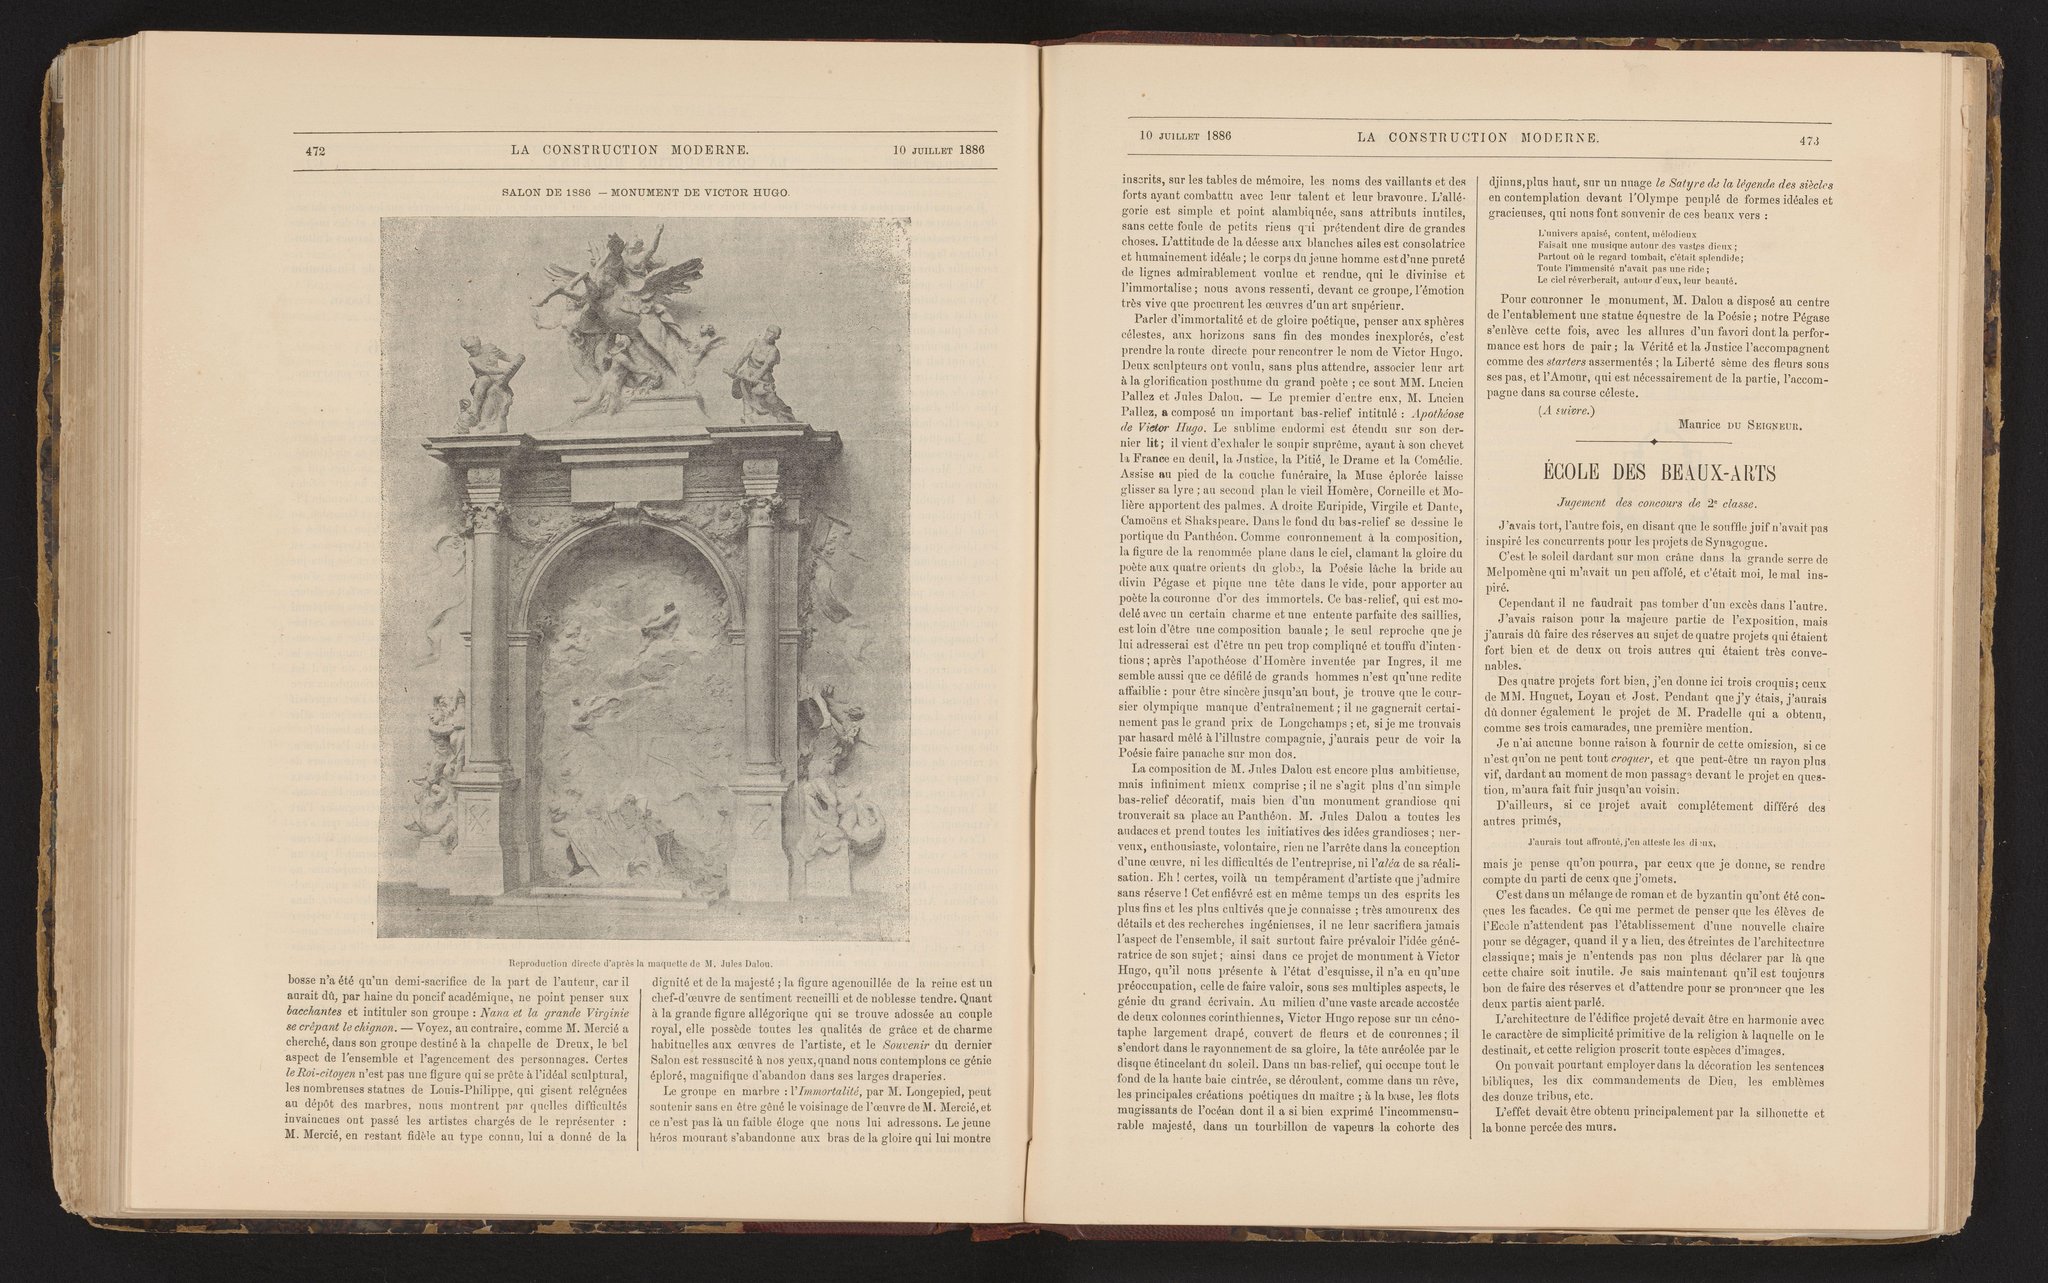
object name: page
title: Inzending voor de Salon van 1886, een monument voor Victor Hugo door Aime-Jules Dalou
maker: Anonymous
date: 1881-1886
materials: paper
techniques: autotype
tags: paris, victor hugo, arch, archivolt ~ architecture, monument, statue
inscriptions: inscription: ‘Reproduction directe d'après la maquette de M. Jules Dalou.’